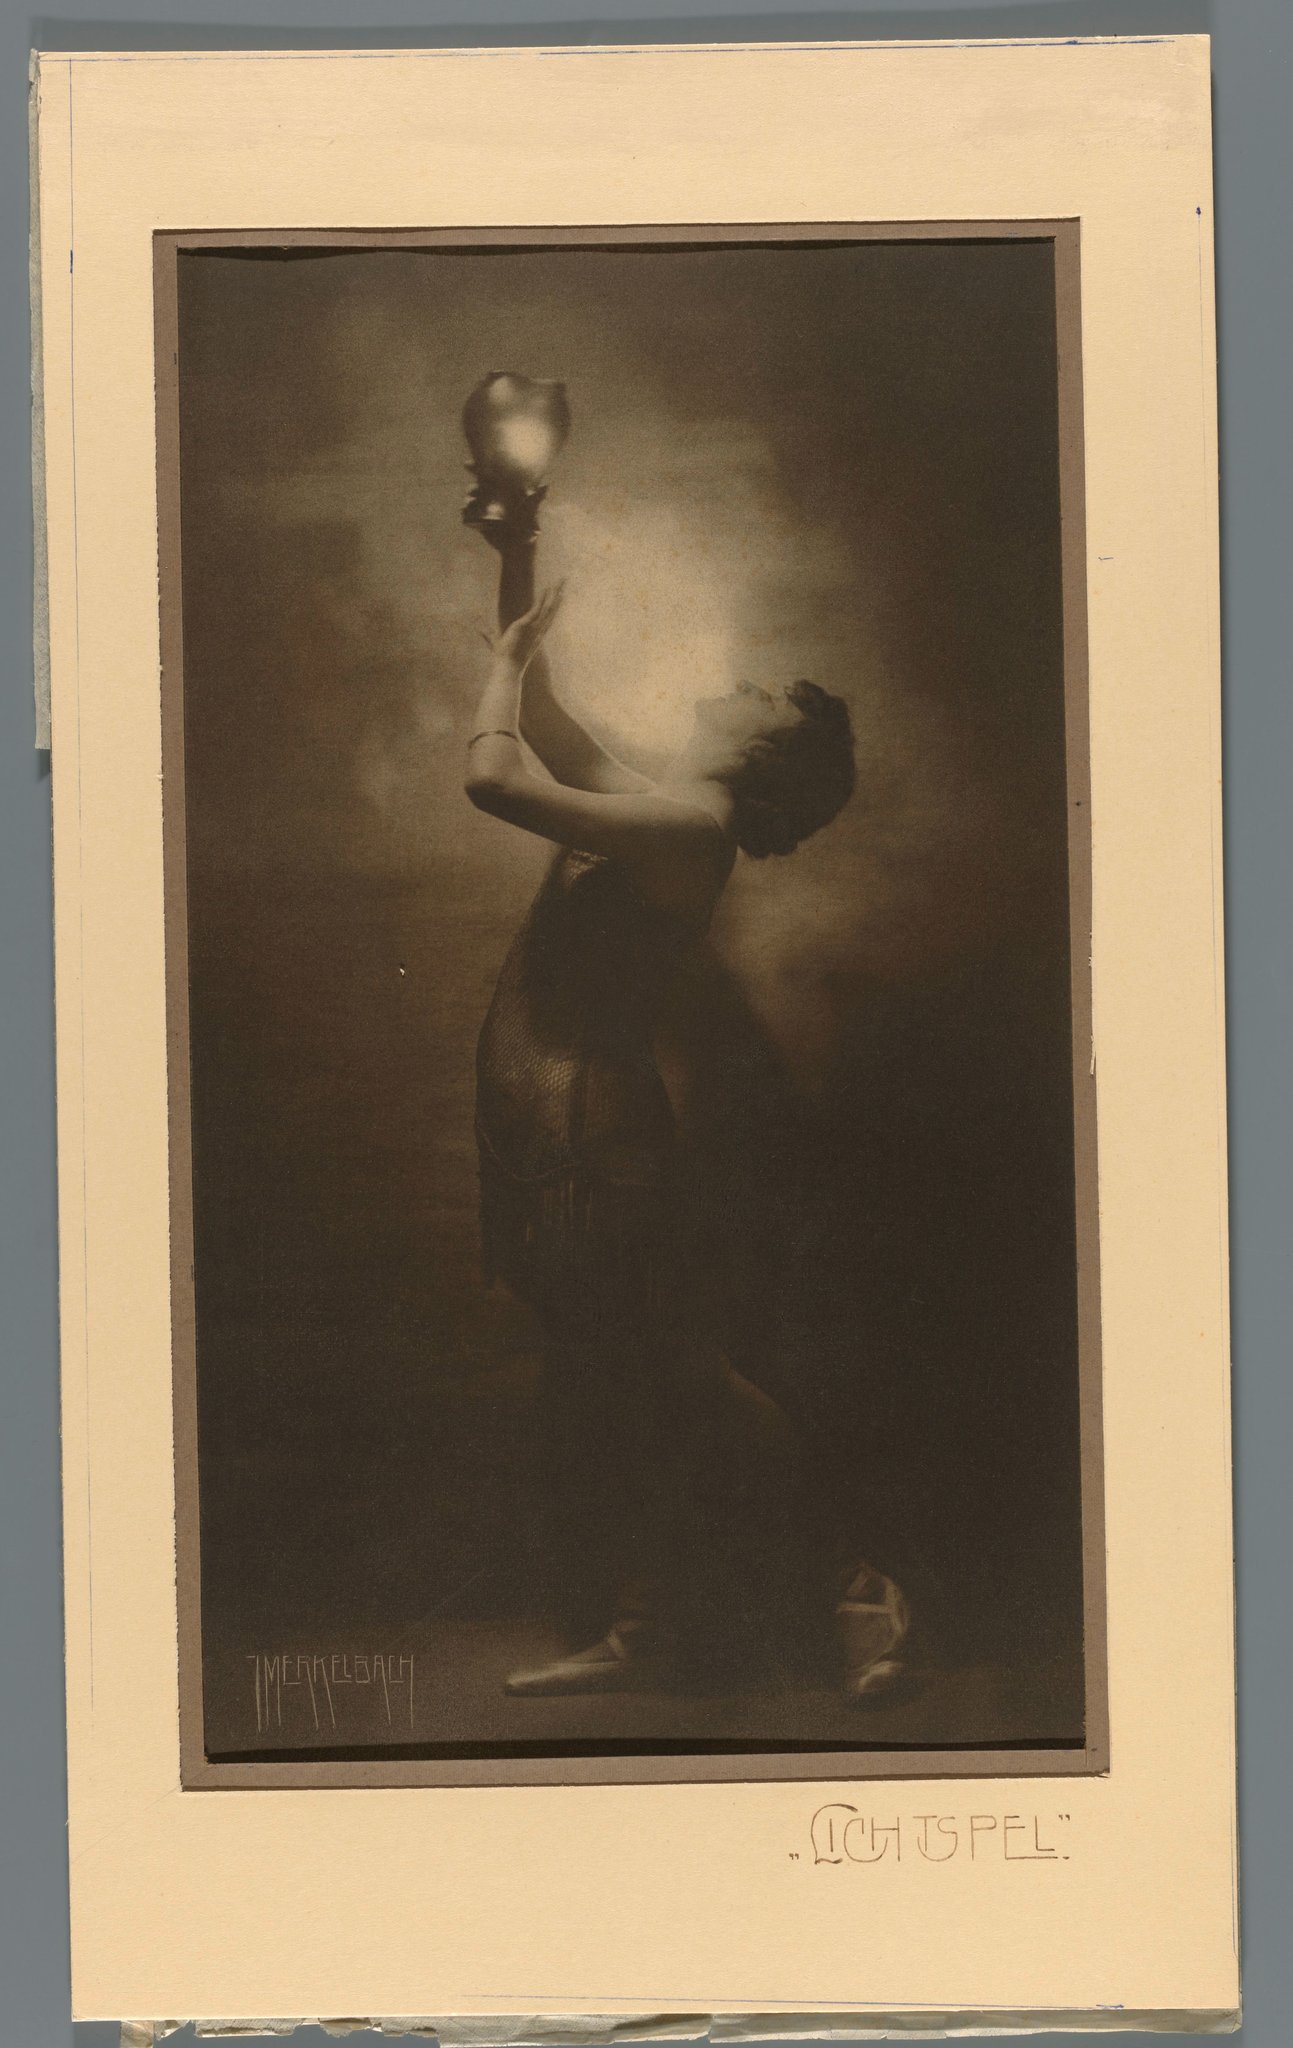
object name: photograph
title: Danseres met lichtbol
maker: jacob merkelbach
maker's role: fotograaf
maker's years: 1877-1942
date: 1920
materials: photographic support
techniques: bromoil process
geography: amsterdam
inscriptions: name: ‘J. Merkelbach, Leidscheplein Amsterdam/ lichttegel/ brom verfoverdruk’, annotation: ‘7e jaarlijkse nationale tentoonstelling van fotowerken’